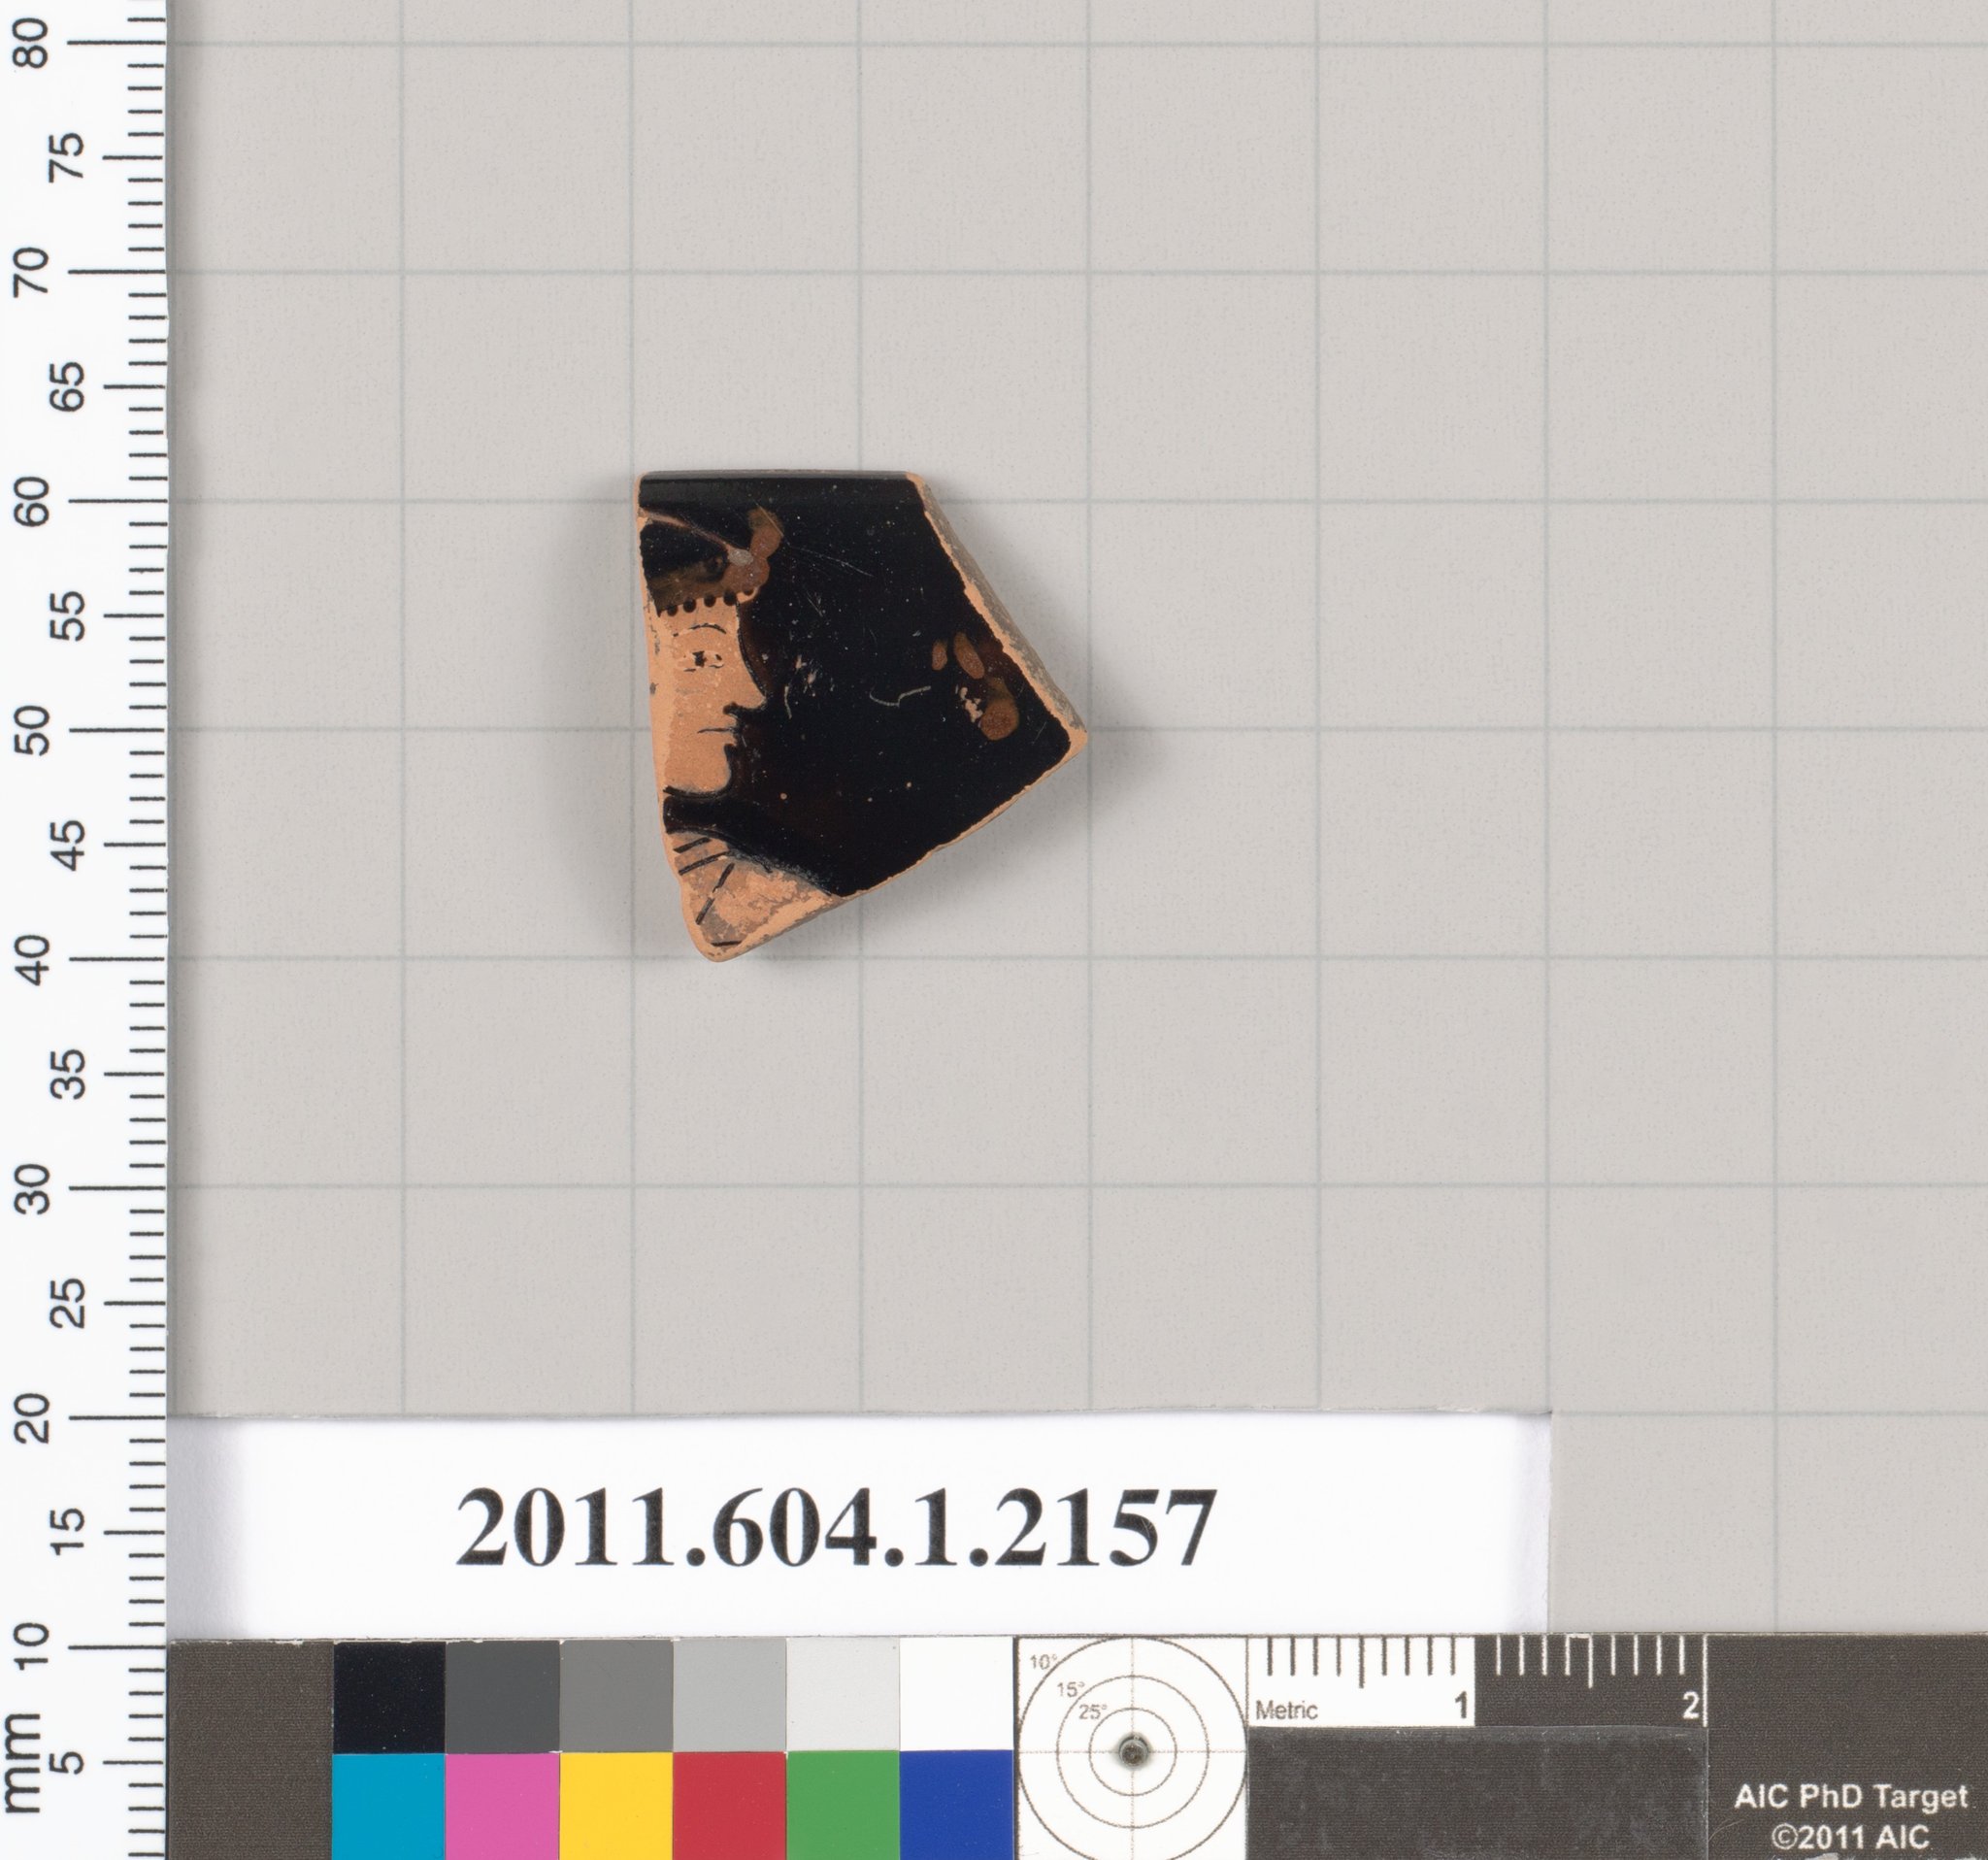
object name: kylix fragment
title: Terracotta rim fragment of a kylix (drinking cup)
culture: greek, attic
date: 401-425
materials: terracotta